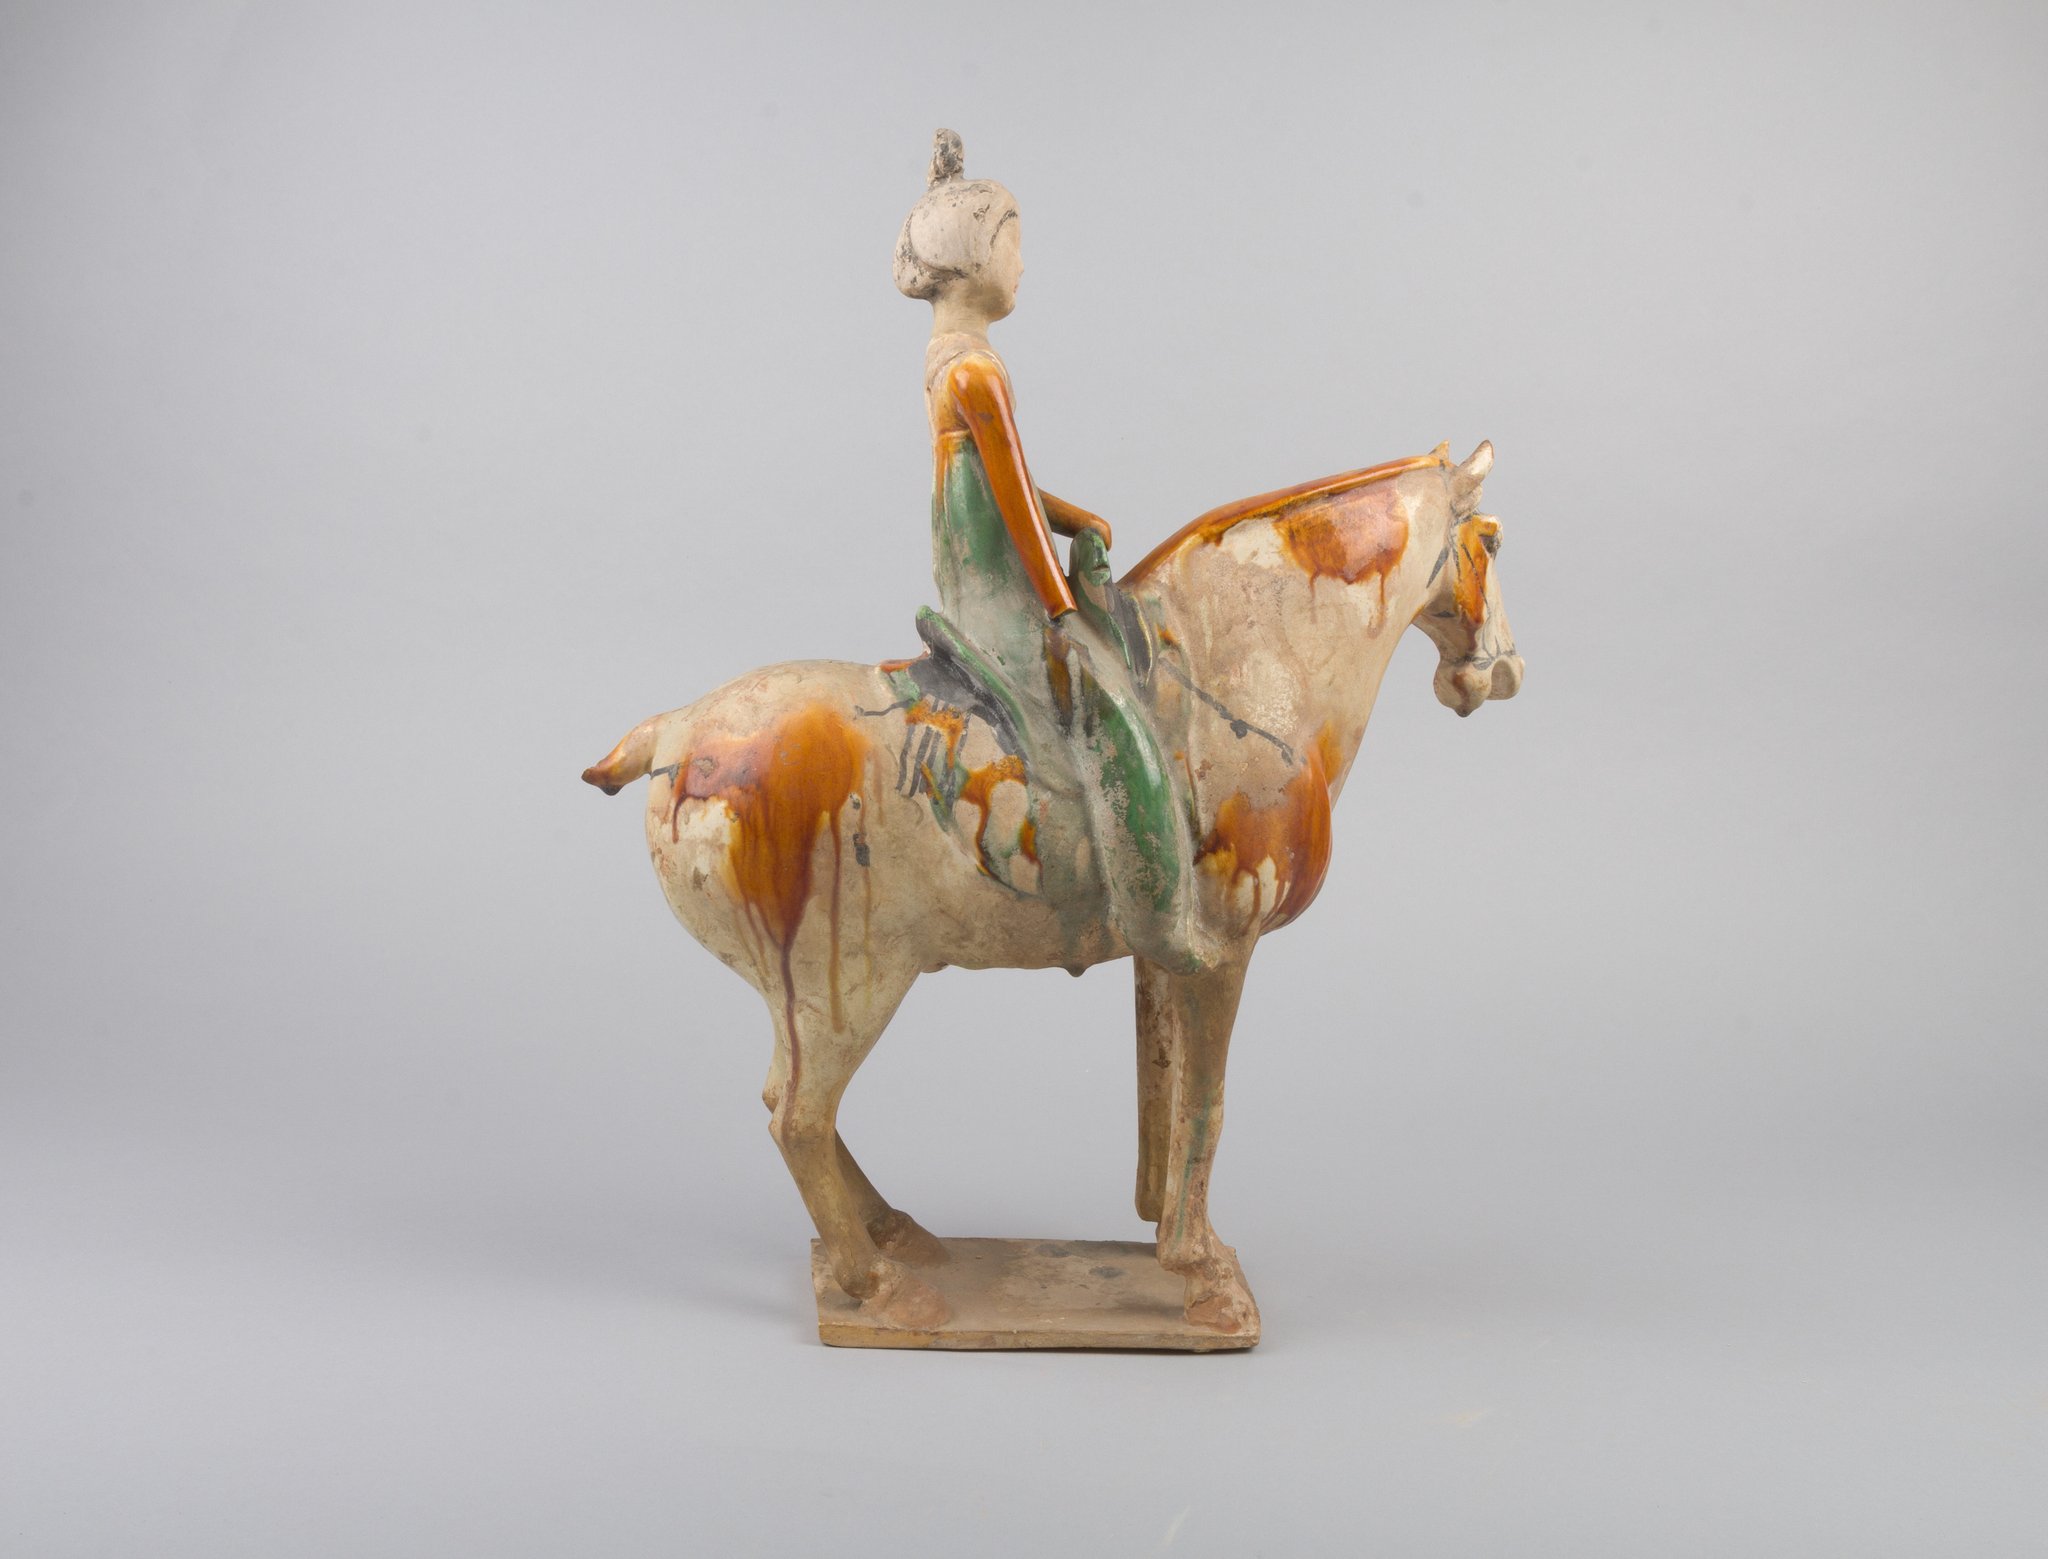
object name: figure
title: Horse and female rider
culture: chinese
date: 601-800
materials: earthenware, glaze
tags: women,horses